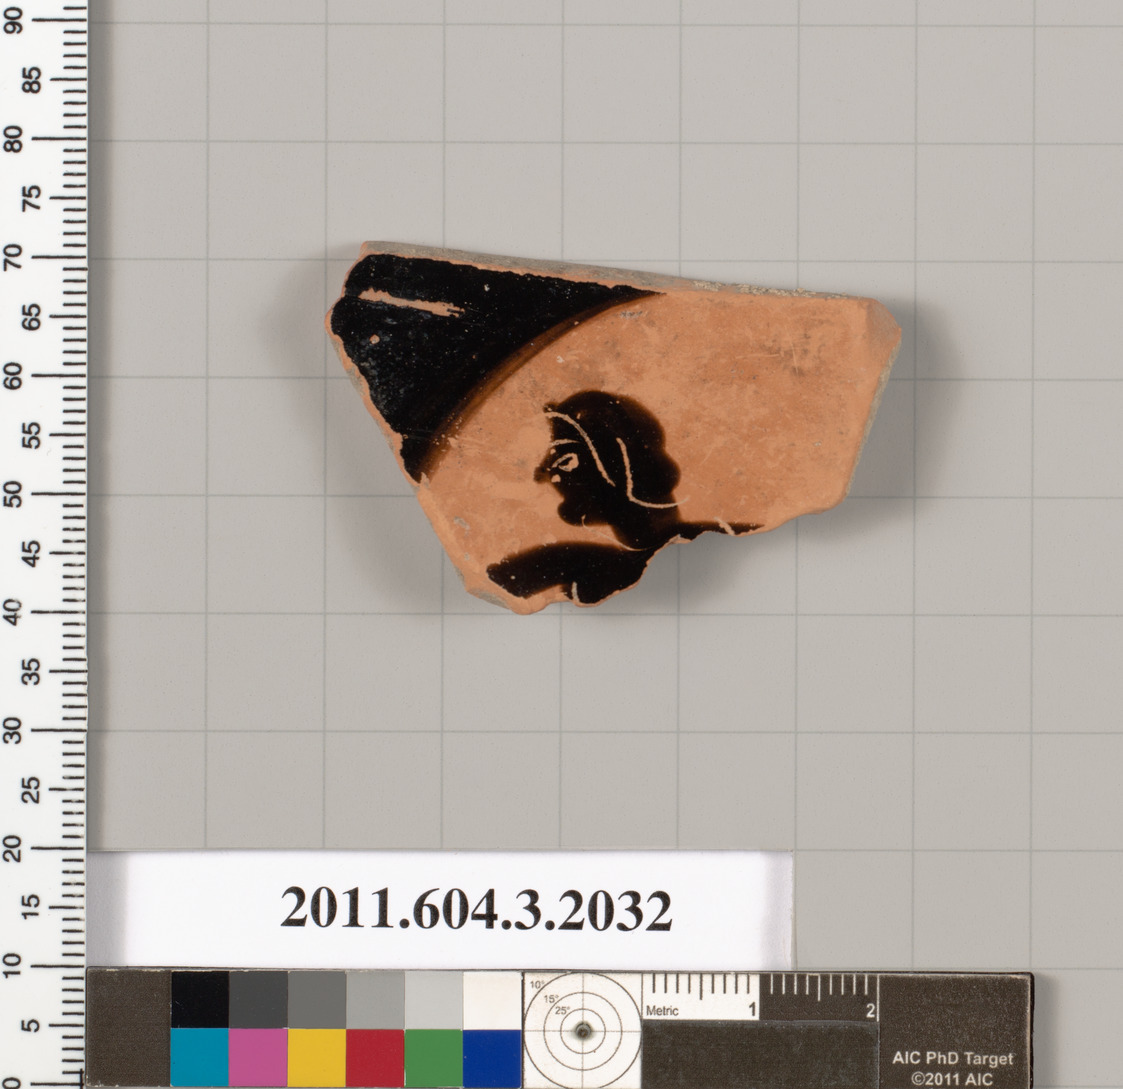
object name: kylix fragment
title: Terracotta fragment of a kylix (drinking cup)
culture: greek, attic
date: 534-468 BCE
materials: terracotta